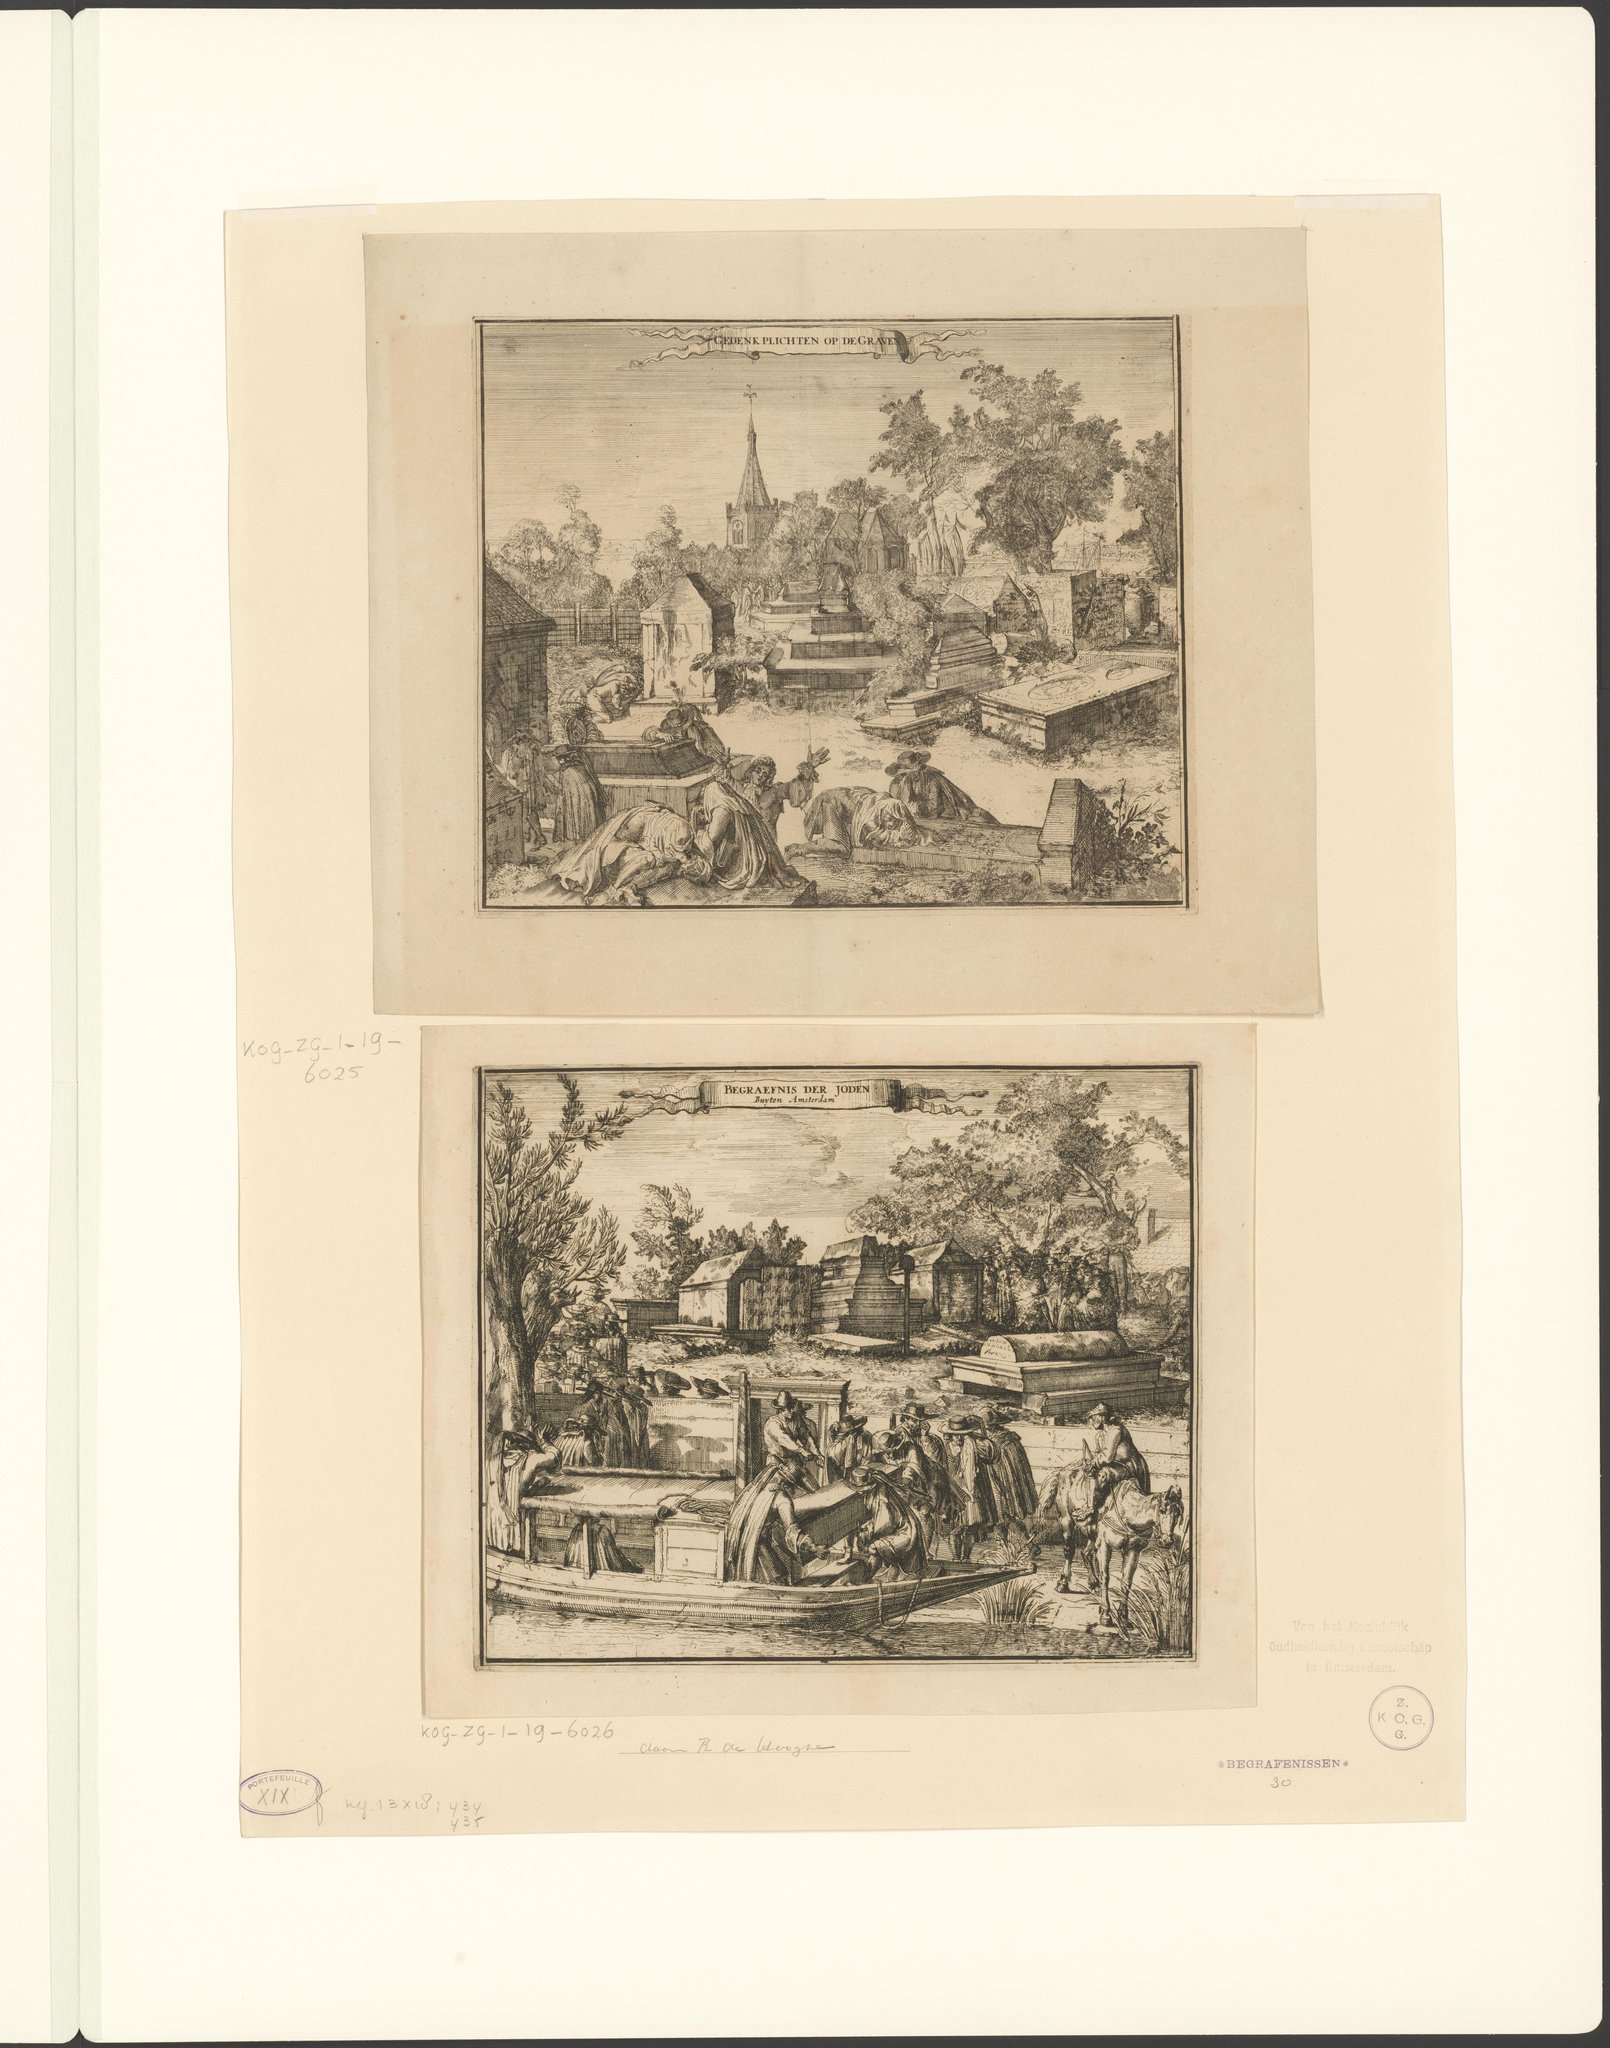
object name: print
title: Gedenk plichten op de graven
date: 1675-1695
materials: paper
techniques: engraving, etching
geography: amsterdam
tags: 'sephardim' ~ jewish communities, churchyard, cemetery, death and burial ~ jewish customs, jewish mourning customs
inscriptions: collector's mark, collector's mark: Lugt 1641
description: Gezicht op de Portugees-Joodse begraafplaats Beth Haim te Ouderkerk aan de Amstel. Bij de graven verschillende rouwende mannen. In het midden de tombe van Isaac Uziel met rechts daarvan, minder goed zichtbaar, die van Elia Montalto. Op de achtergrond de kerk van Ouderkerk. Boven in het midden een banderol met de titel. Onderwerpsrubrieken binnen de Atlas Zeden en Gewoonten: Des Menschen Begin, Midden en Einde. Begrafenissen, begrafenisplechtigheden bij de Joden.